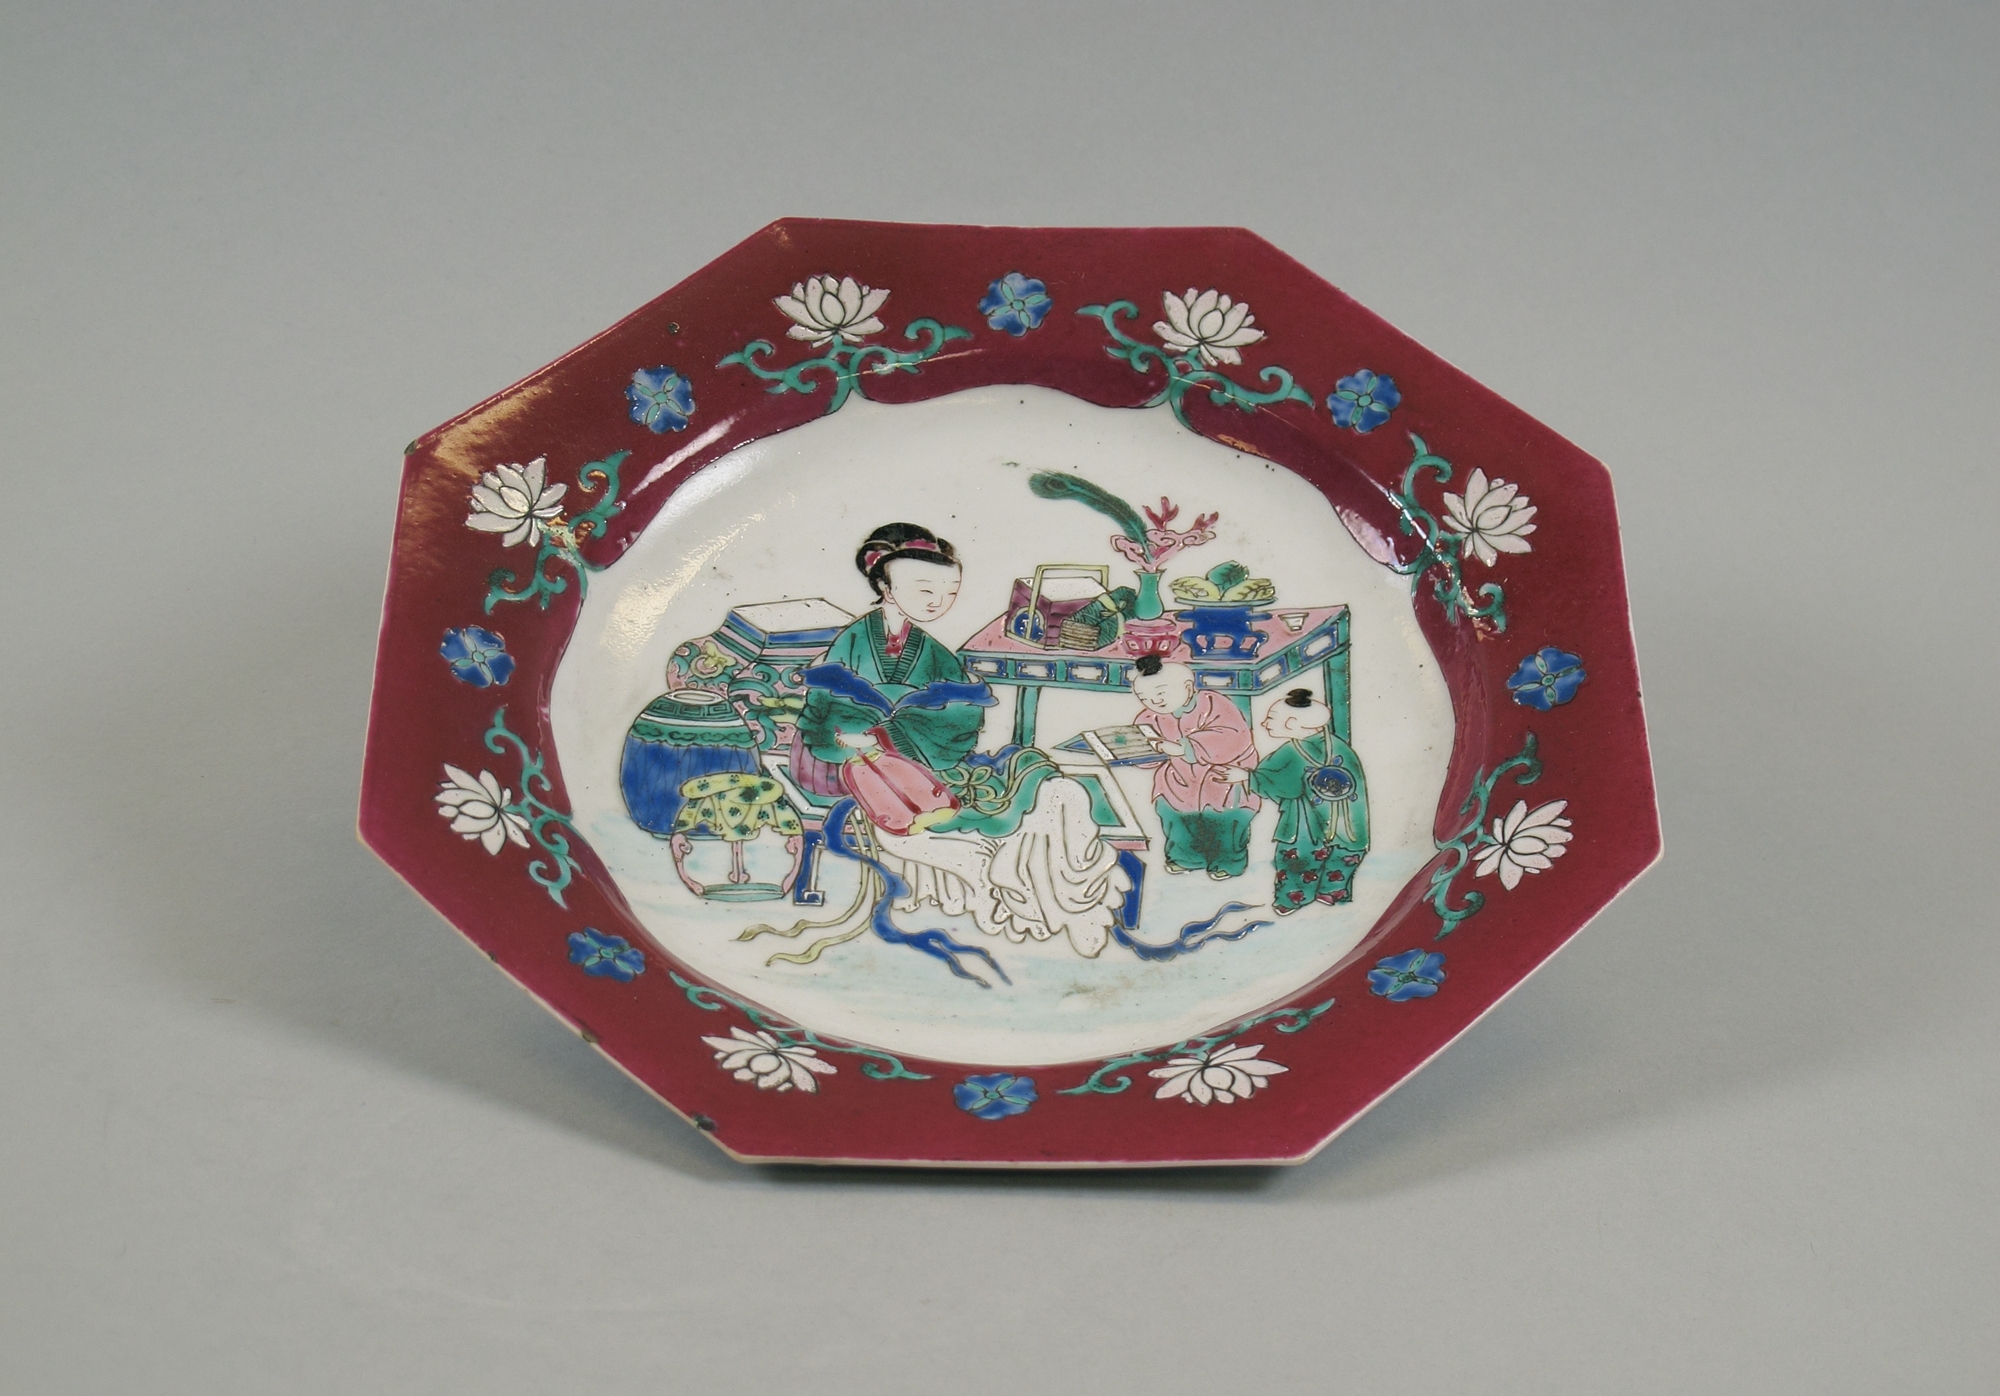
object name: plate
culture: chinese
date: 1736-1795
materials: porcelain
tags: boys,women,lotuses